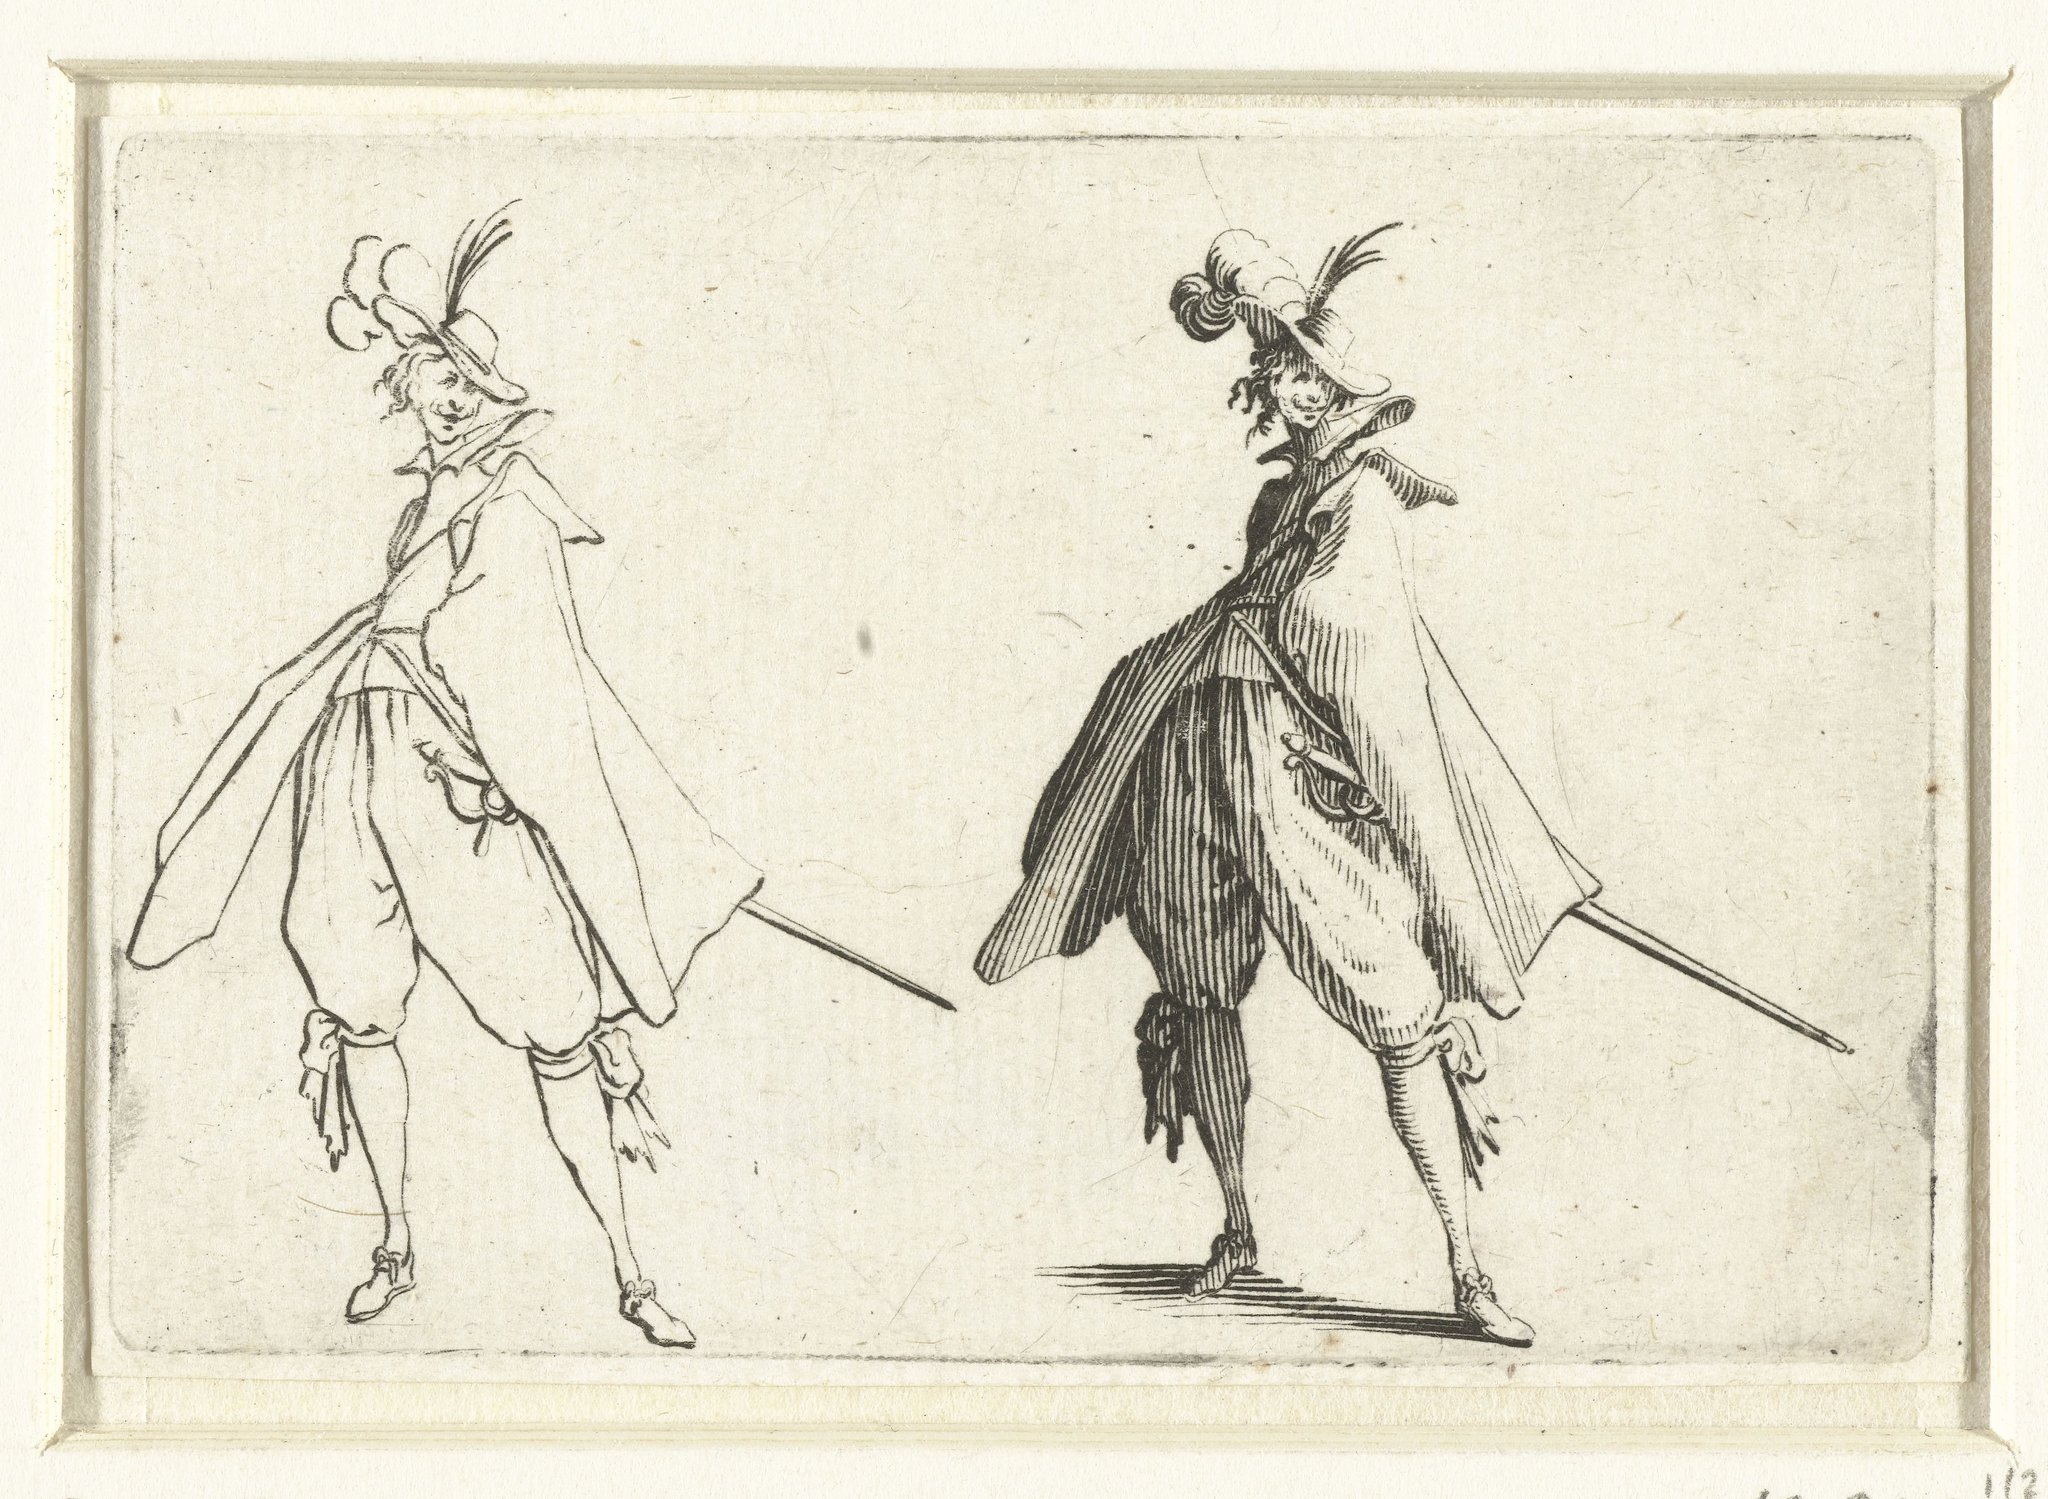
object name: print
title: Diverse figuren en voorstellingen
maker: jacques callot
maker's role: draughtsman, print maker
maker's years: 1592-1635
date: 1621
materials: paper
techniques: etching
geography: nancy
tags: coat (+ men's clothes), head-gear: hat (+ men's clothes), hacking and thrusting weapons: sword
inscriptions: collector's mark: Lugt 240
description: Een heer met een hoed op en een mantel om, een zwaard aan de linkerzijde, van voren gezien, tweemaal afgebeeld: links als lijnfiguur, rechts meer uitgewerkt met schaduwpartijen. Deze prent is onderdeel van een serie van 48 prenten (50 incl. titelblad en dedicatieblad) met diverse onderwerpen (o.a. mannen en vrouwen in verschillende houdingen, landschappen, gebouwen en festiviteiten in Florence). Mogelijk zijn deze prenten bedoeld geweest als tekenvoorbeelden.